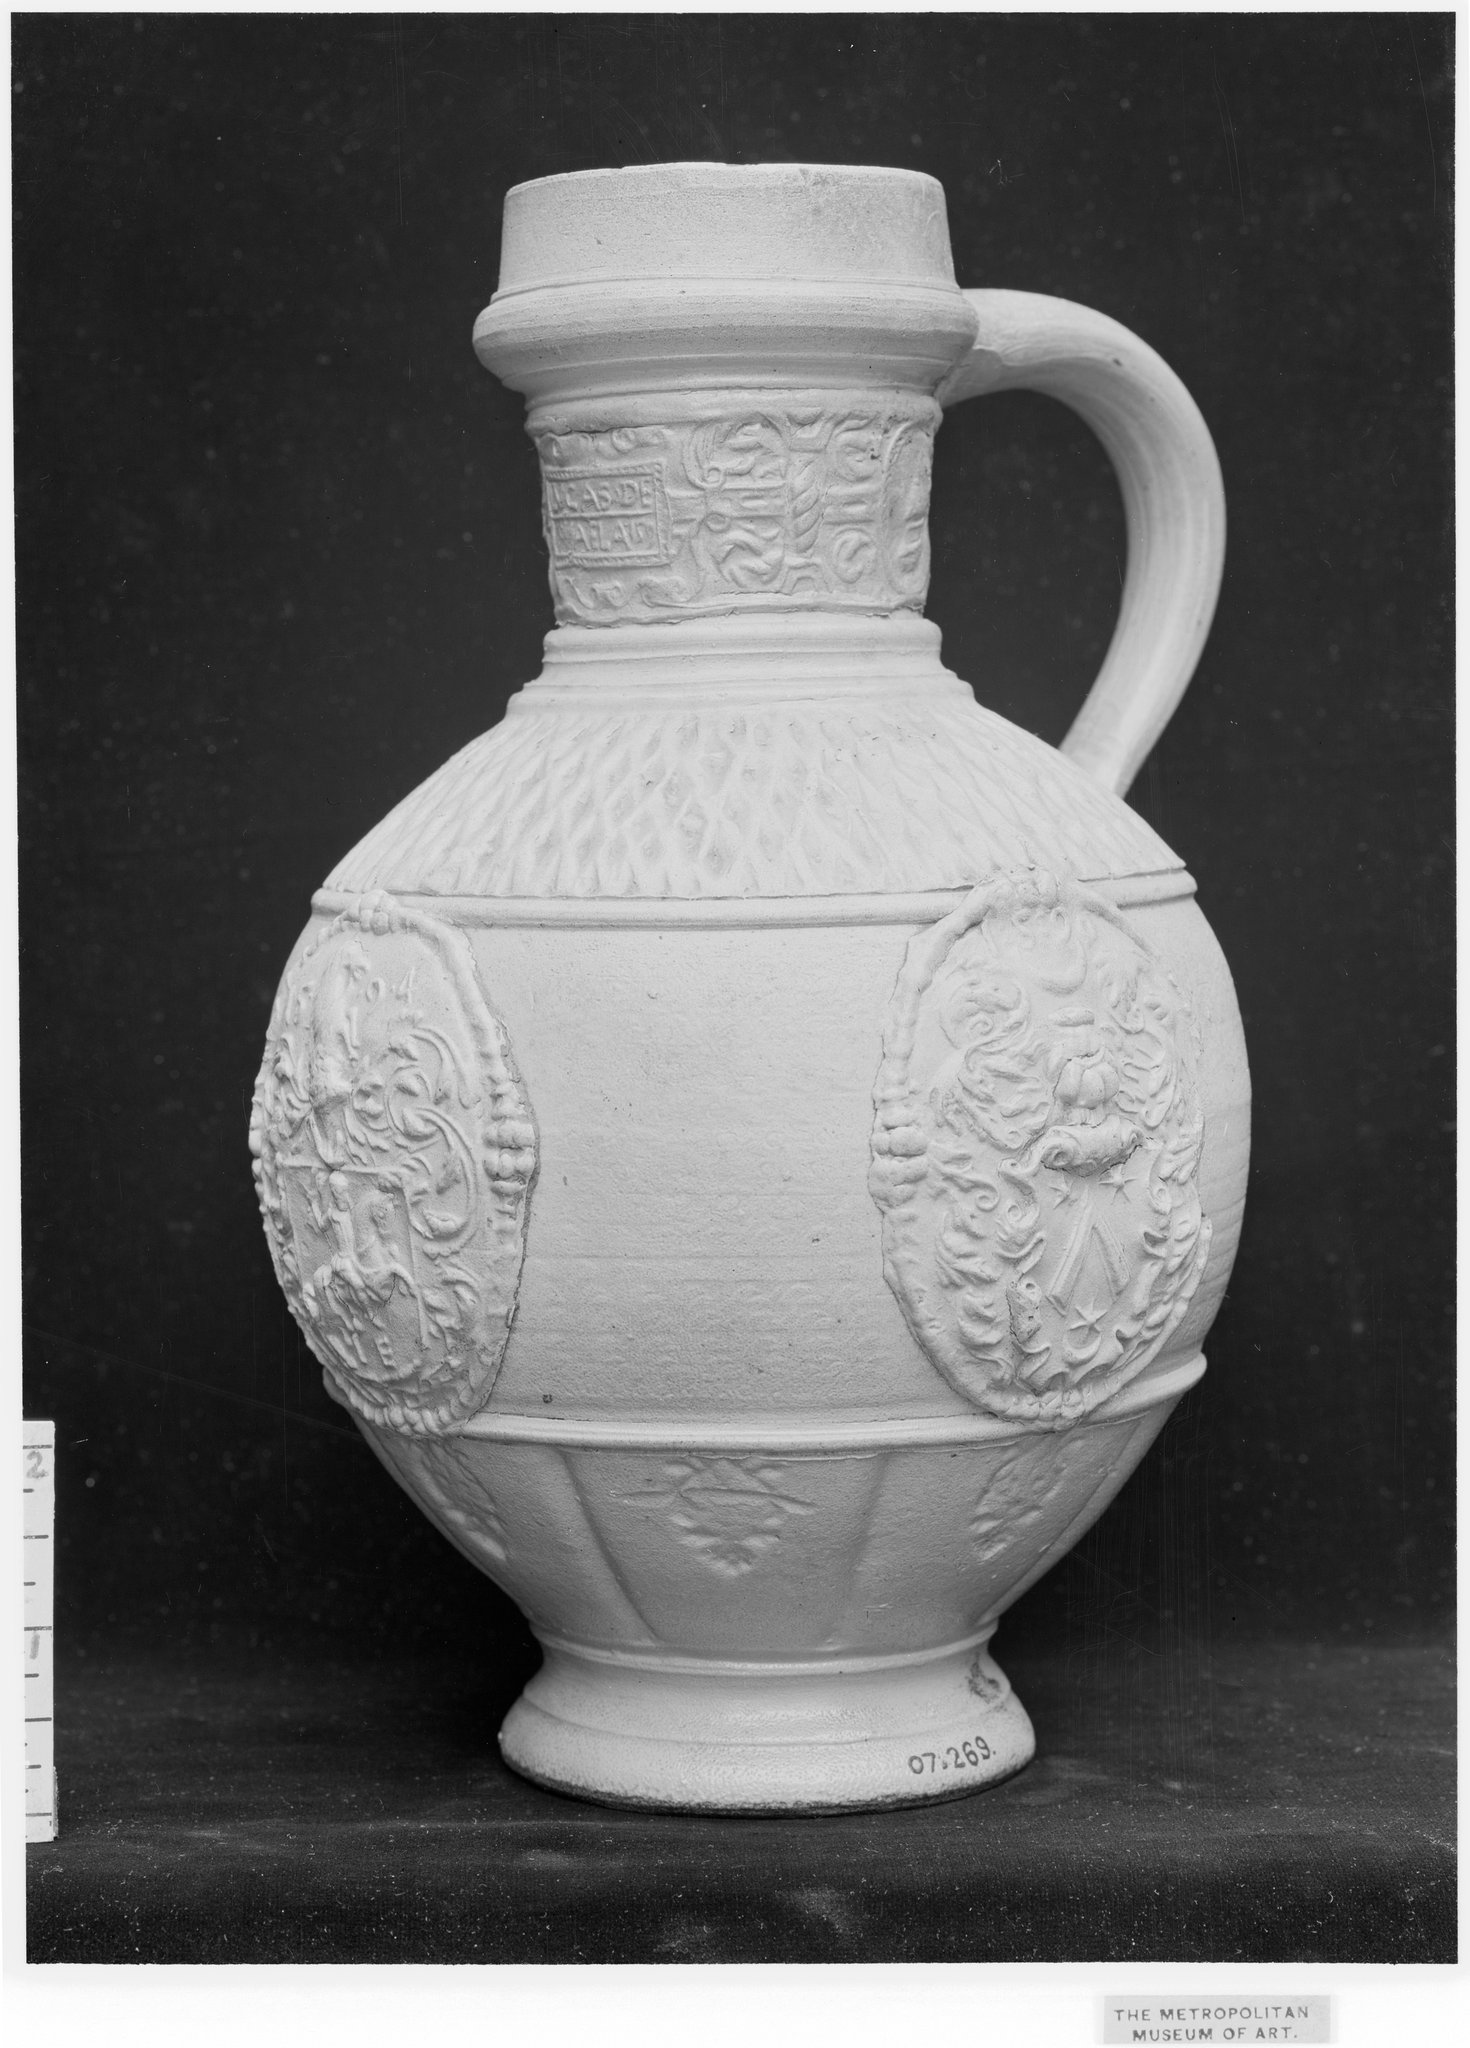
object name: jug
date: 1601-1900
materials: stoneware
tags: coat of arms